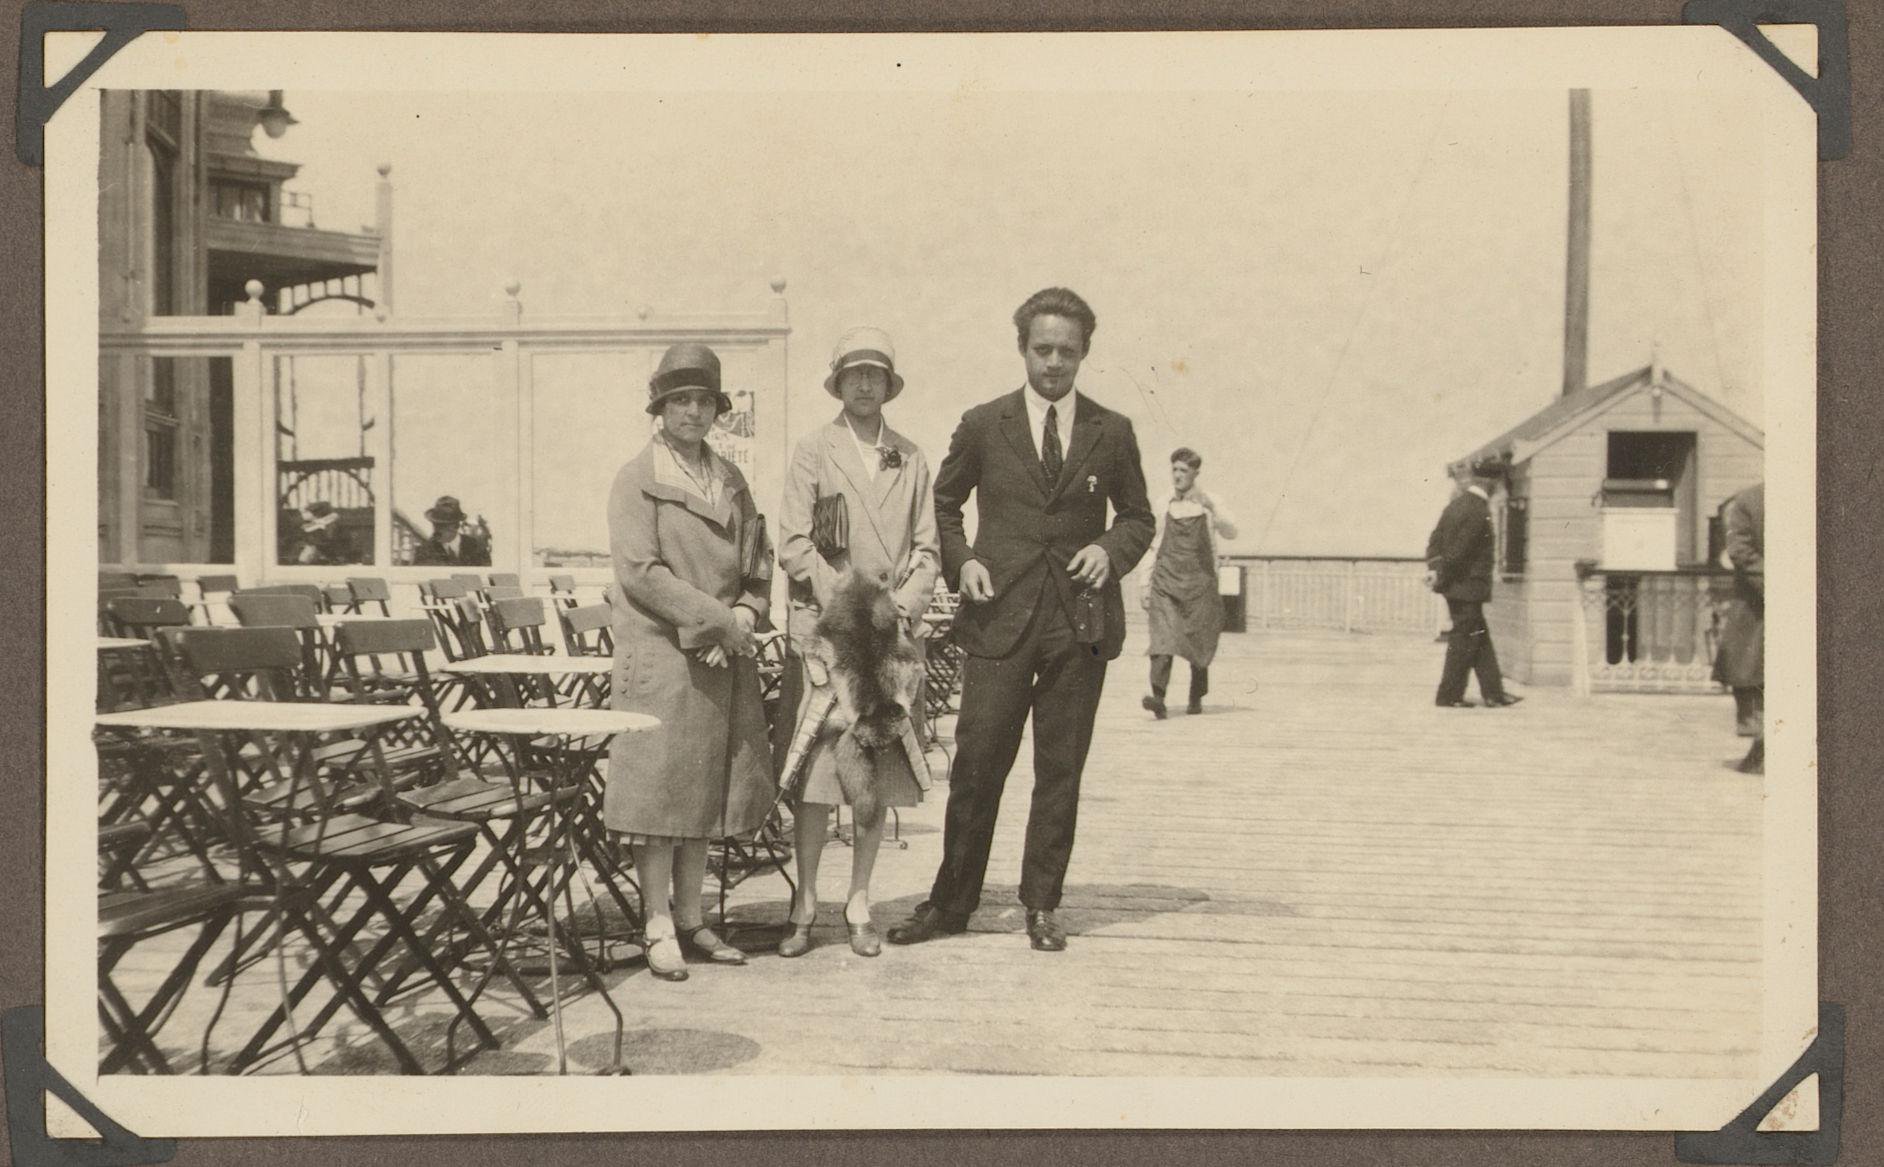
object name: album leaf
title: Portret van Henriëtte Wassink, met haar dochter Dootje en zoon Johannes op de pier van Scheveningen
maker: Anonymous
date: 1930-1935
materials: paper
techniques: gelatin silver print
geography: scheveningen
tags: batavia, the hague, henriëtte wassink, amsterdam, adult woman, adult man, historical persons, pavement, terrace in front of inn or restaurant